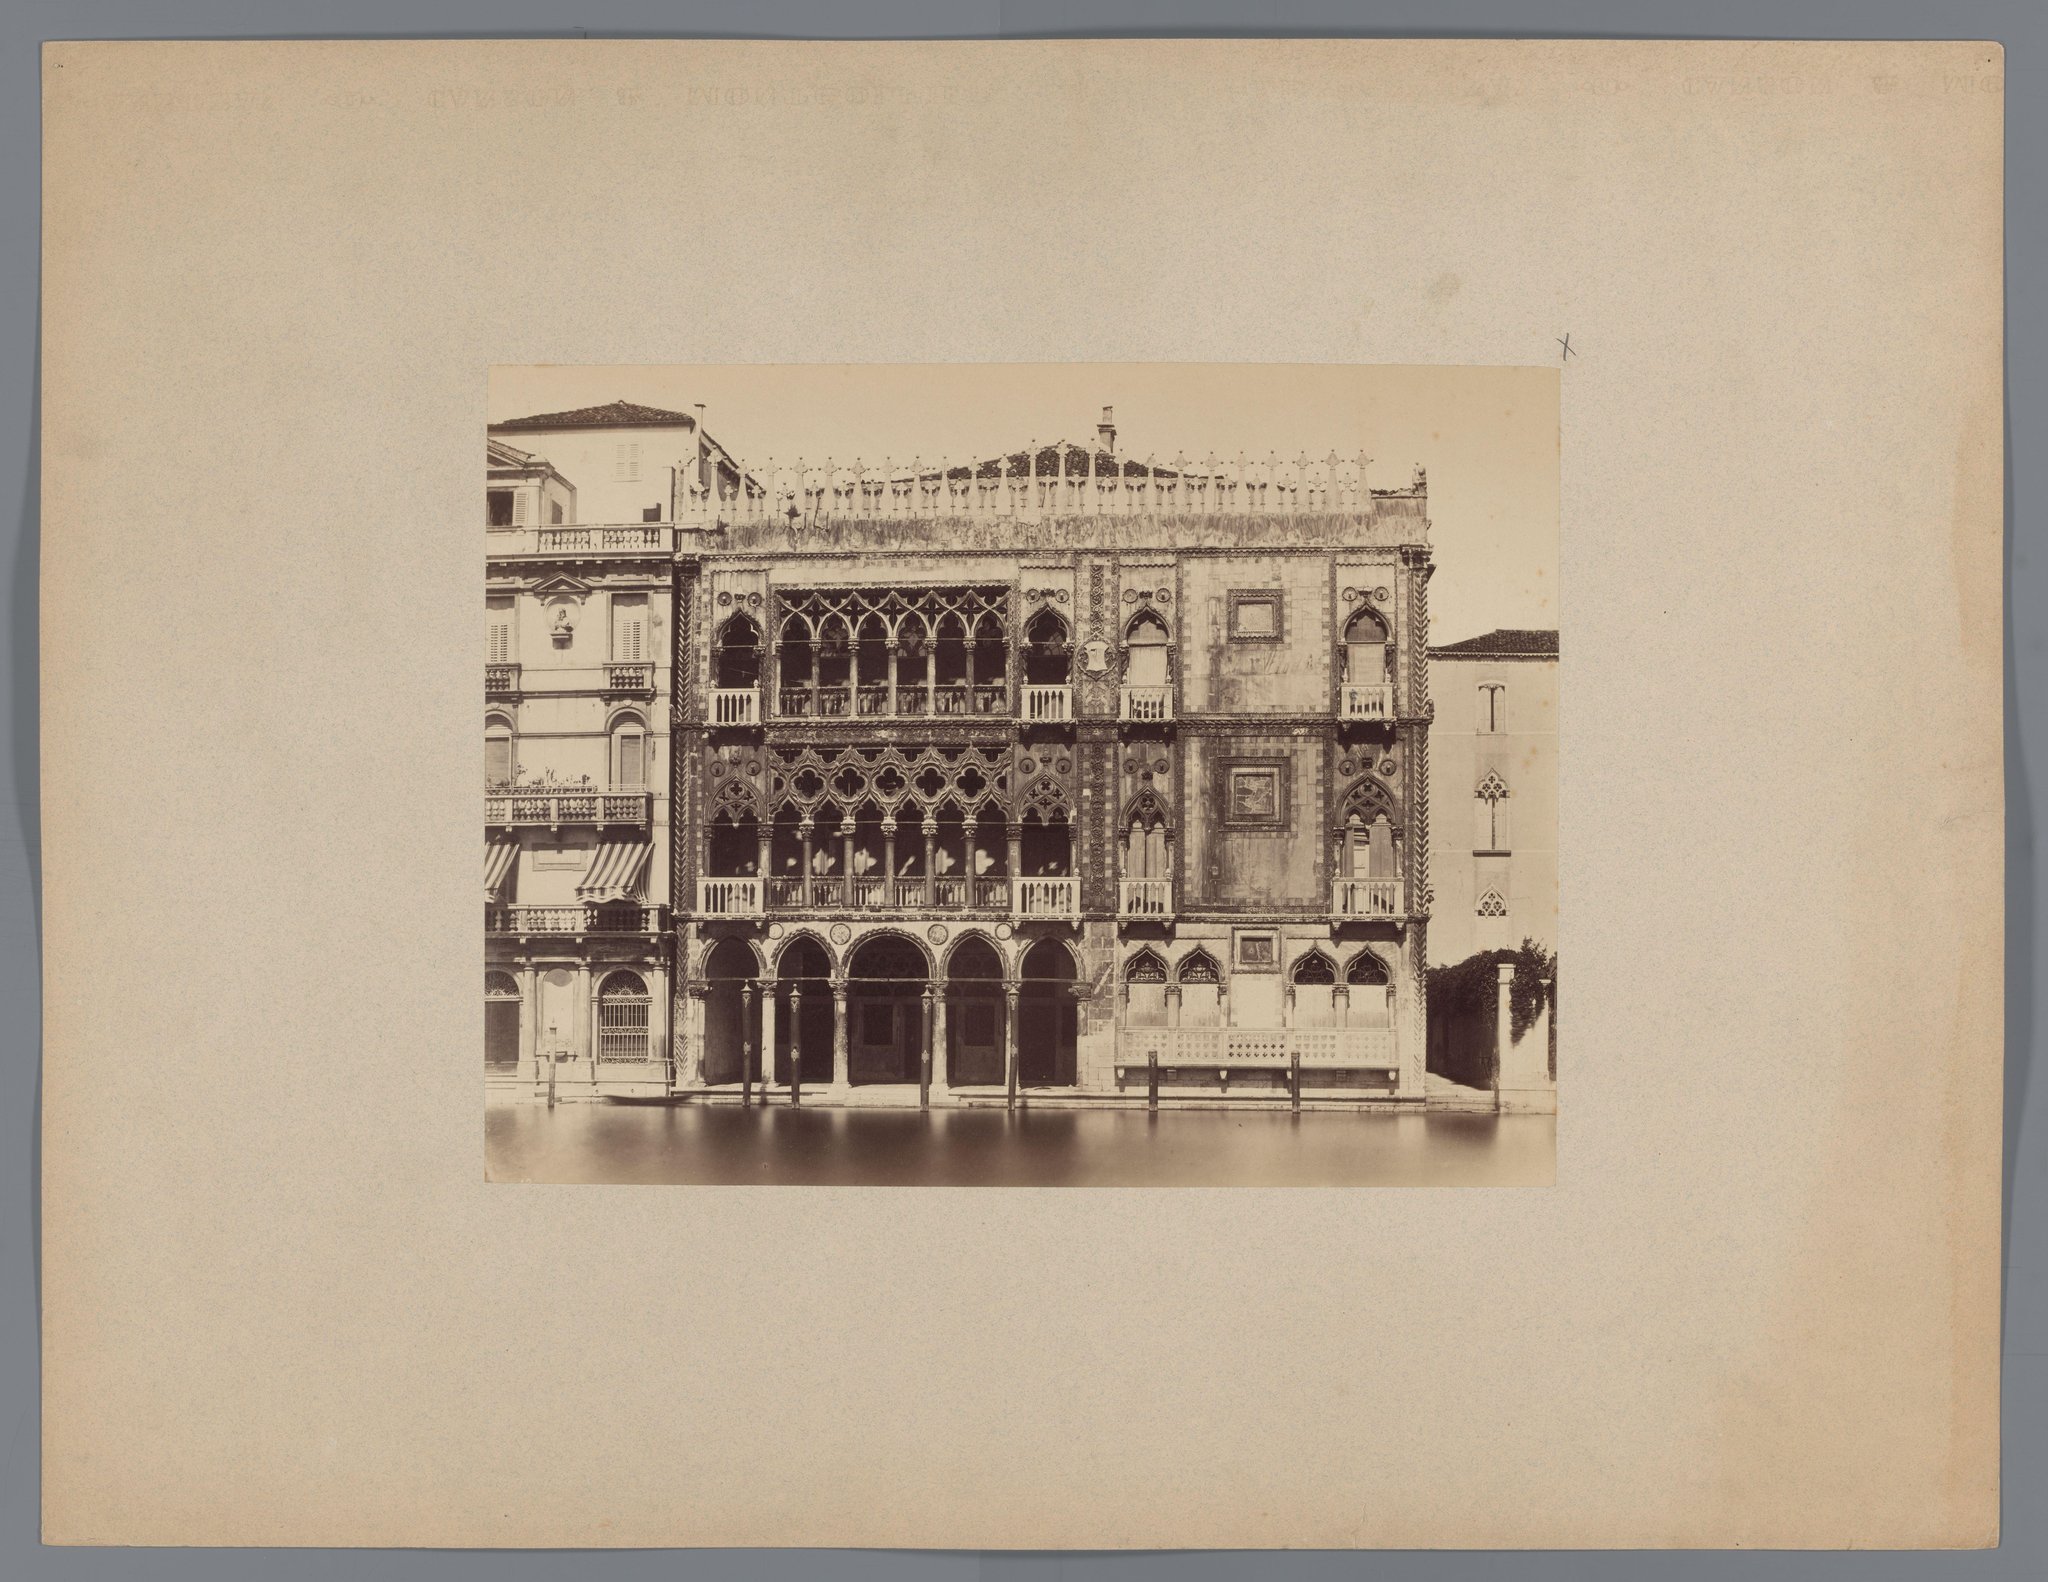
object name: photograph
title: Gezicht op het Ca' d'Oro te Venetië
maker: carlo naya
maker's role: fotograaf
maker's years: 1816-1882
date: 1880-1900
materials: cardboard, photographic support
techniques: albumen print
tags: ca' d'oro